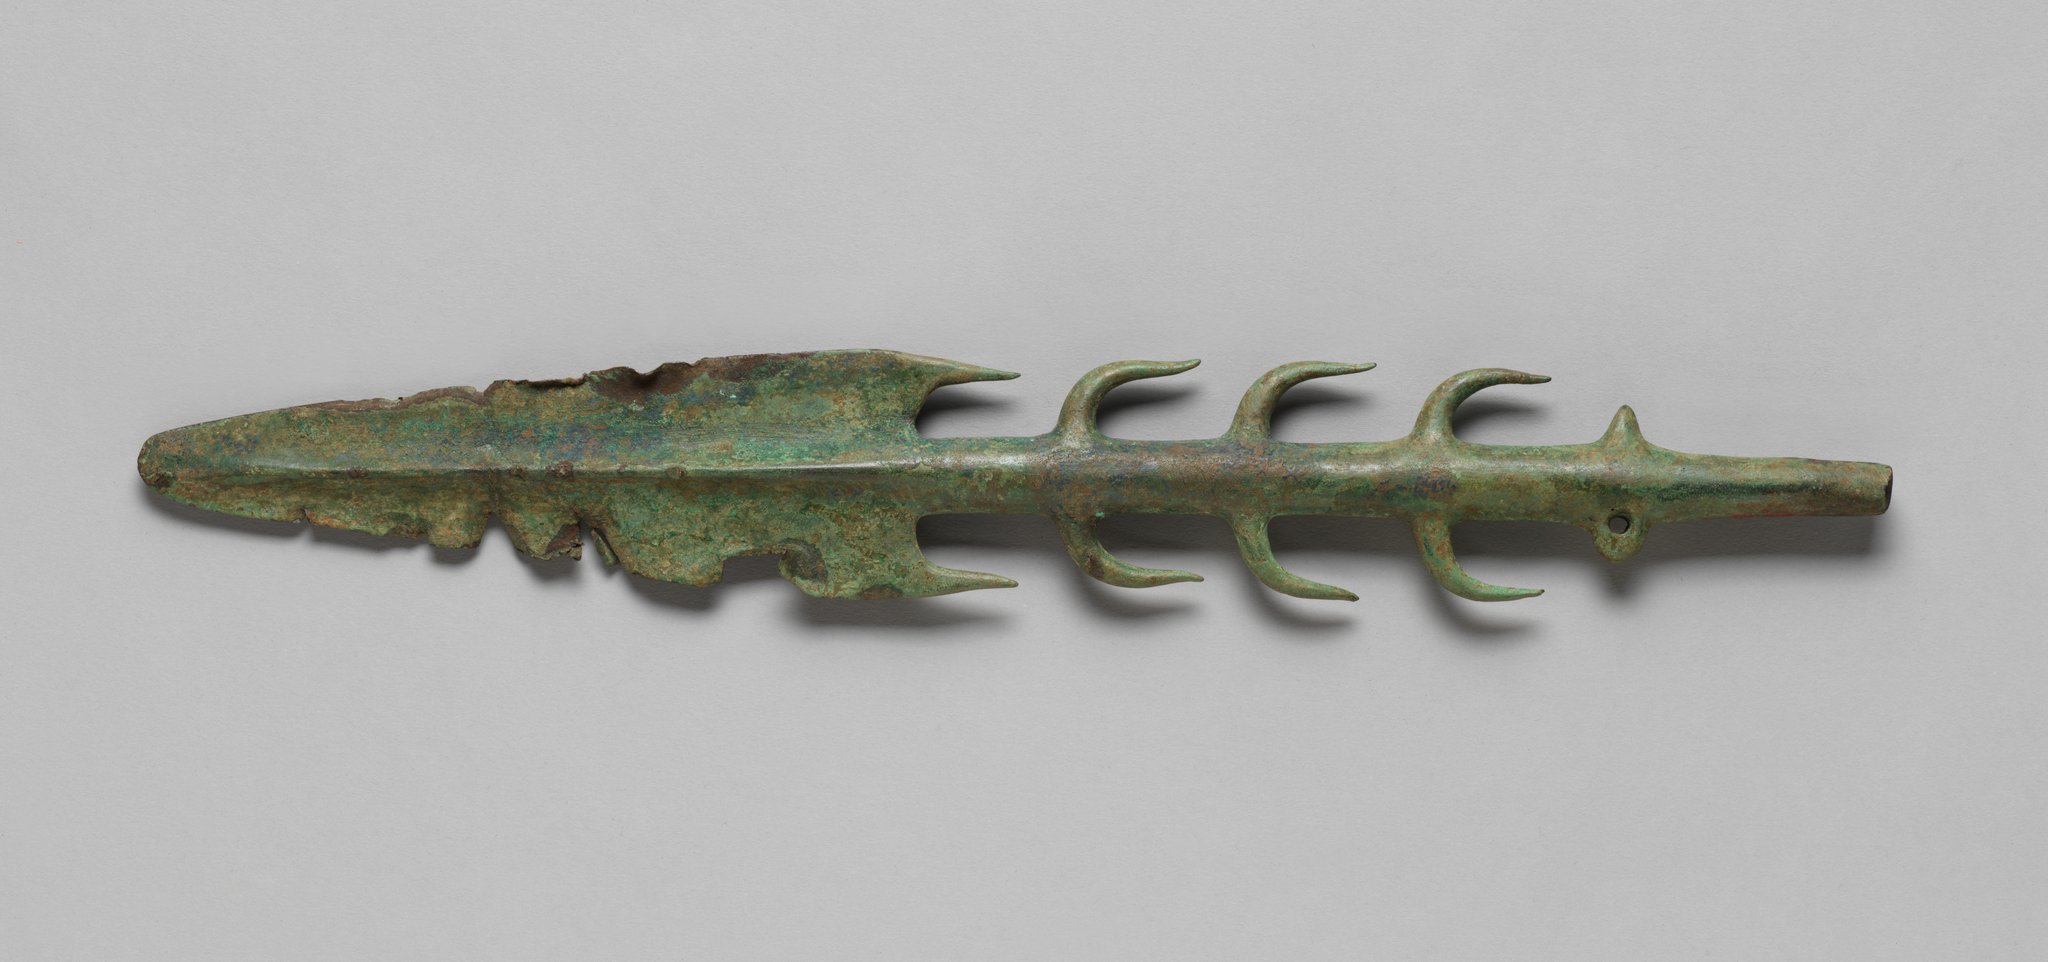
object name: harpoon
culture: indian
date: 1500-1000 BCE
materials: copper